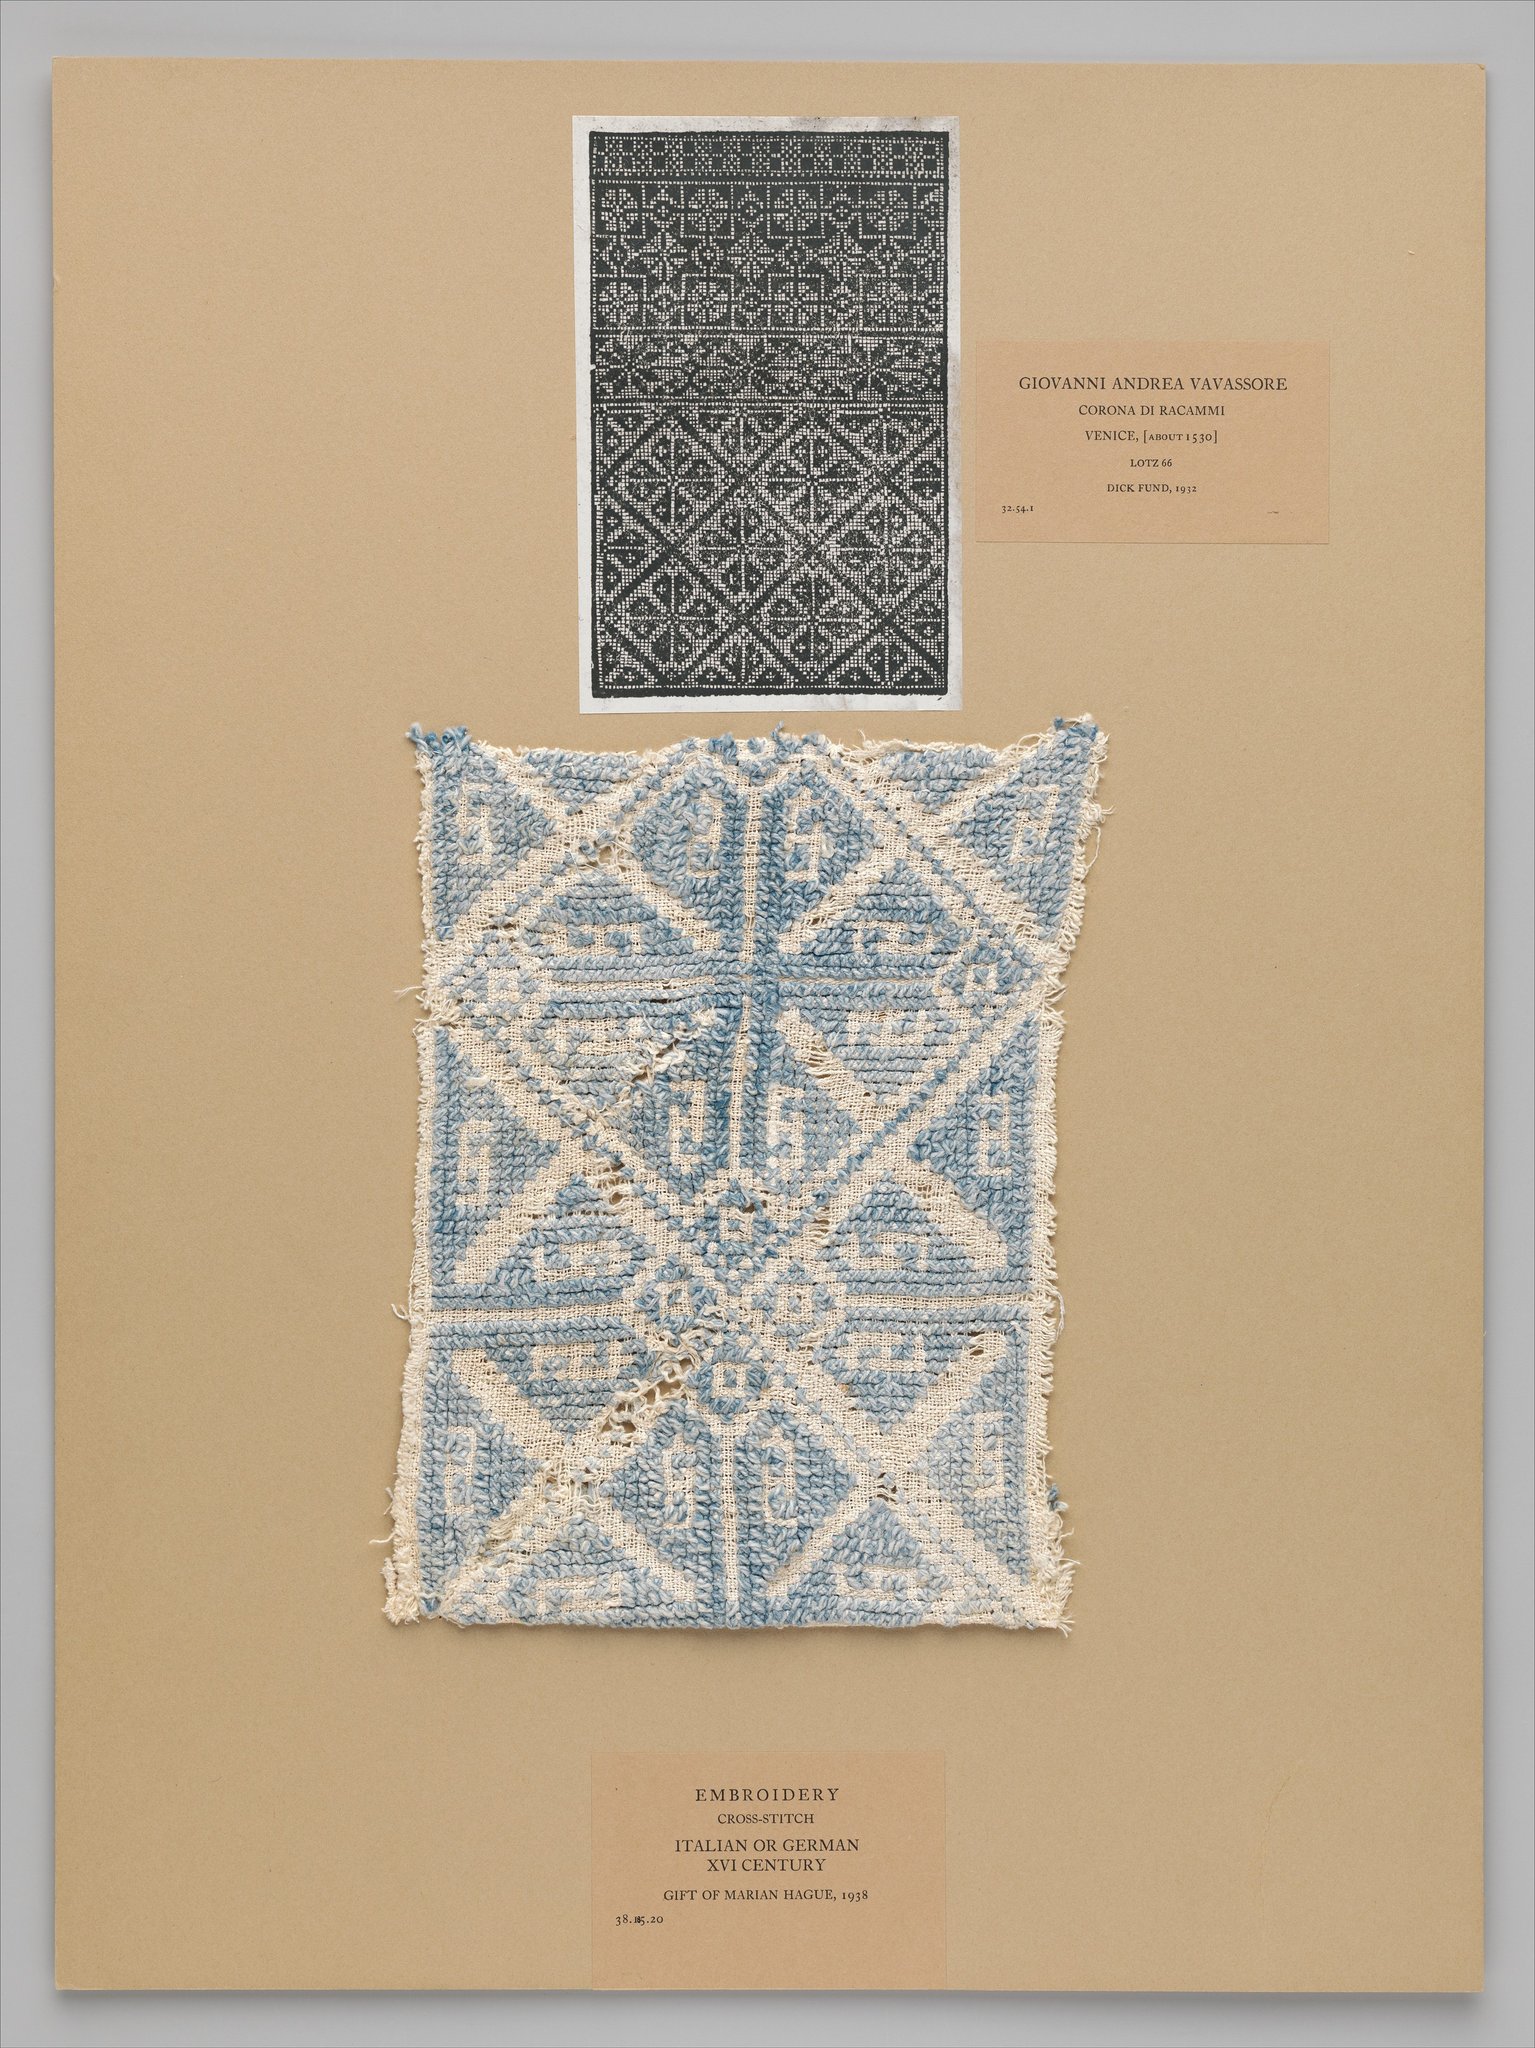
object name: piece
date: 1501-1600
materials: linen